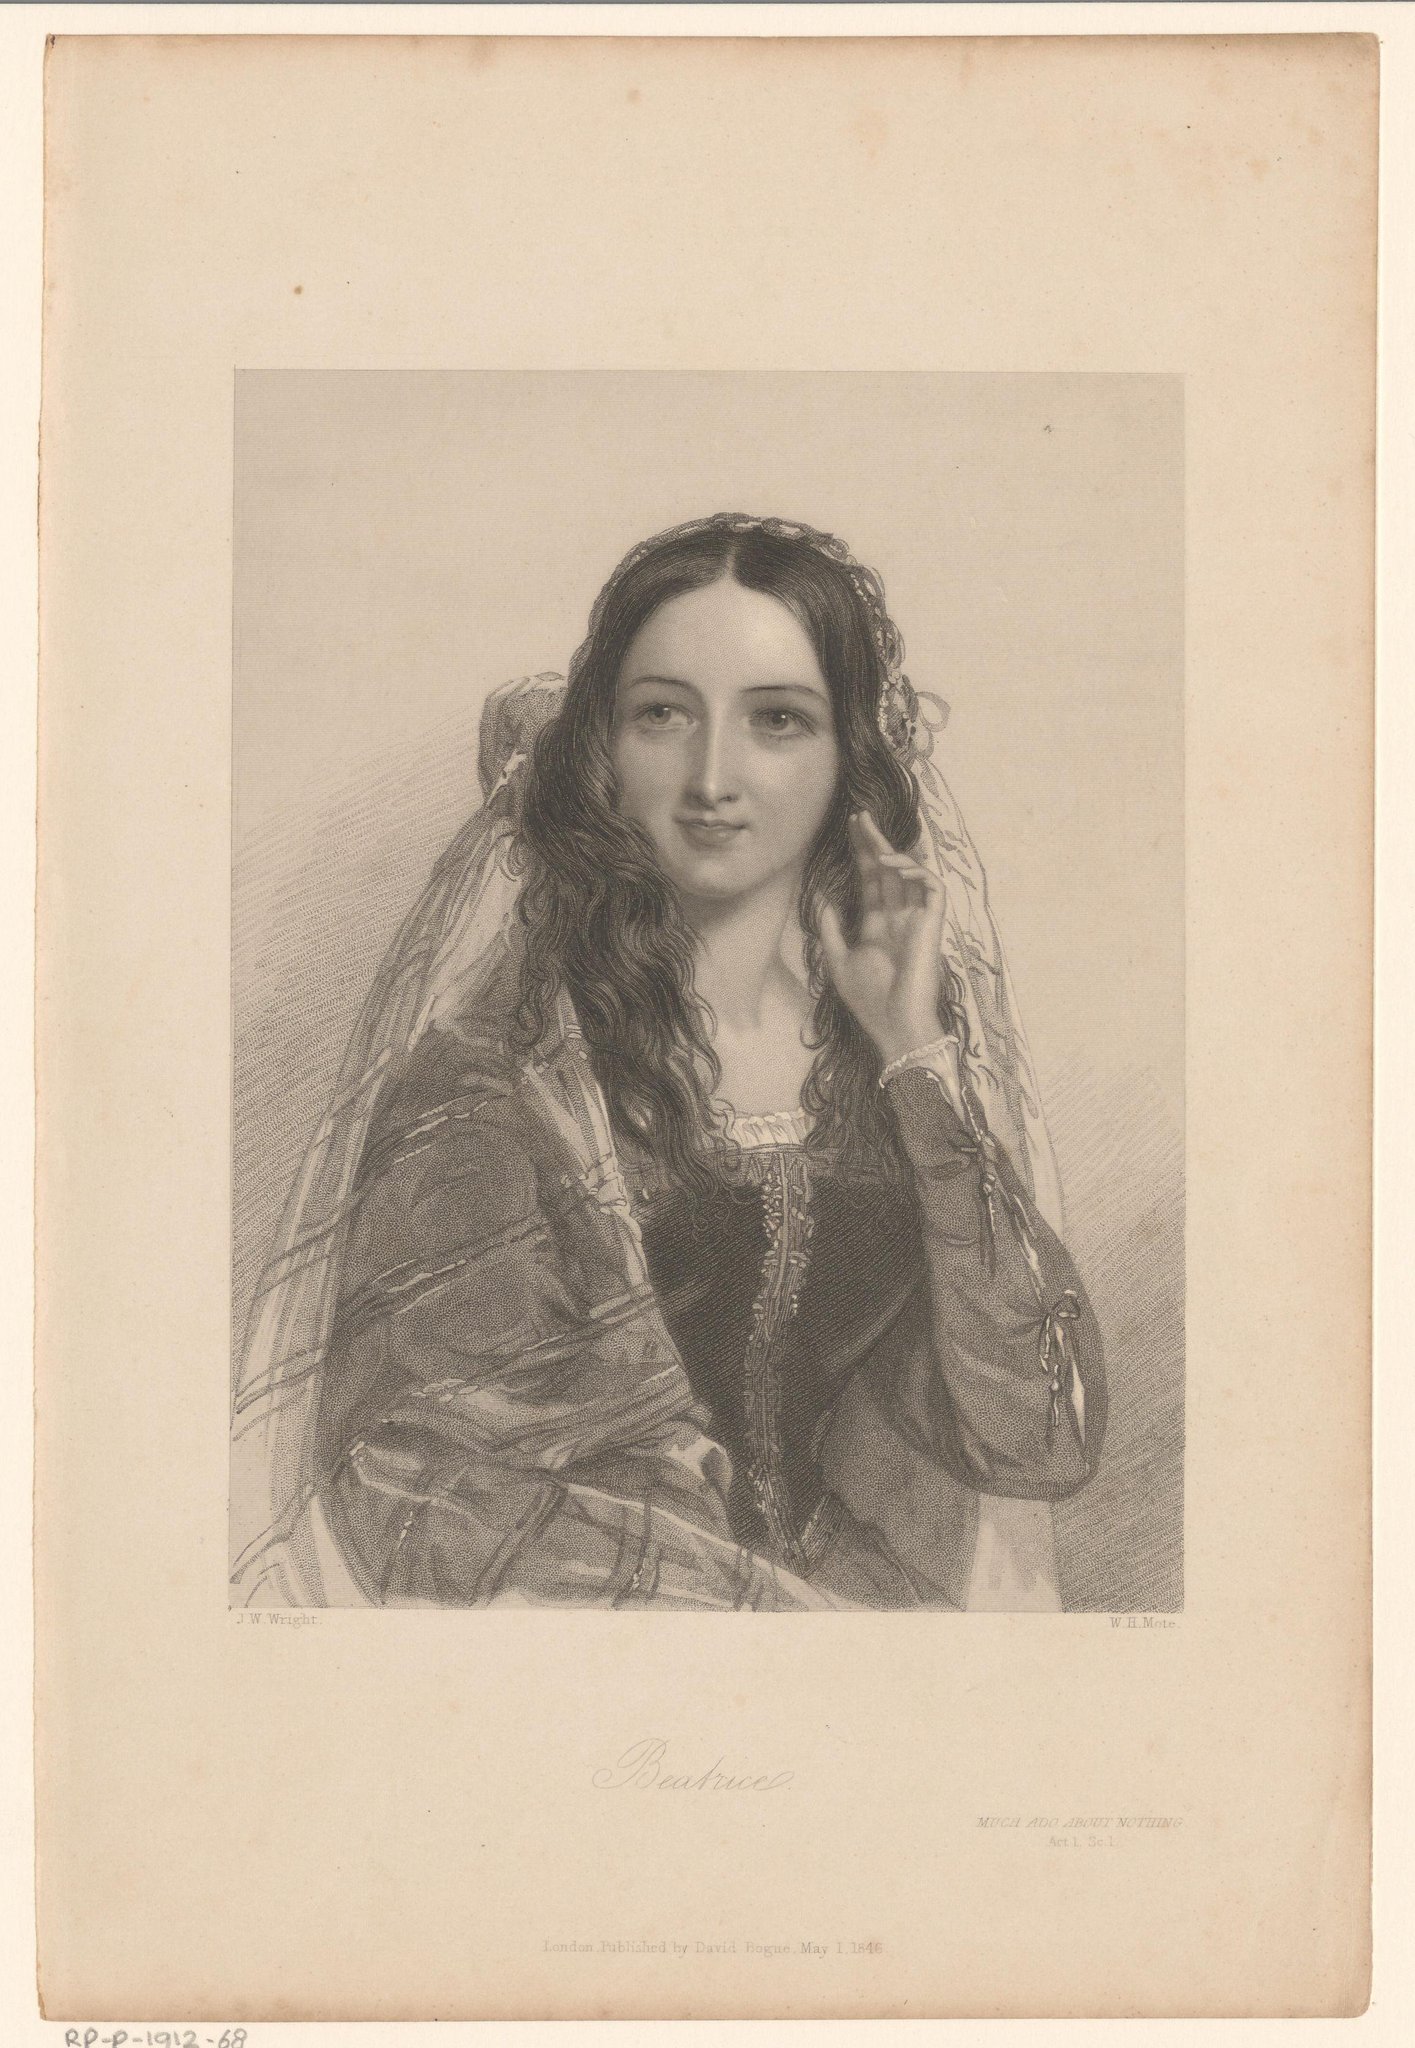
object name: print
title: Beatrice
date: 1805-1846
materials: paper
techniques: etching, roulette, engraving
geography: london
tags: william shakespeare, female literary characters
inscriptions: collector's mark: Lugt 2228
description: Prent ook gebruikt in: Heath, Charles. The heroines of Shakespeare: comprising the principal female characters in the plays of the great poet. Londen: David Bogue, 1848.